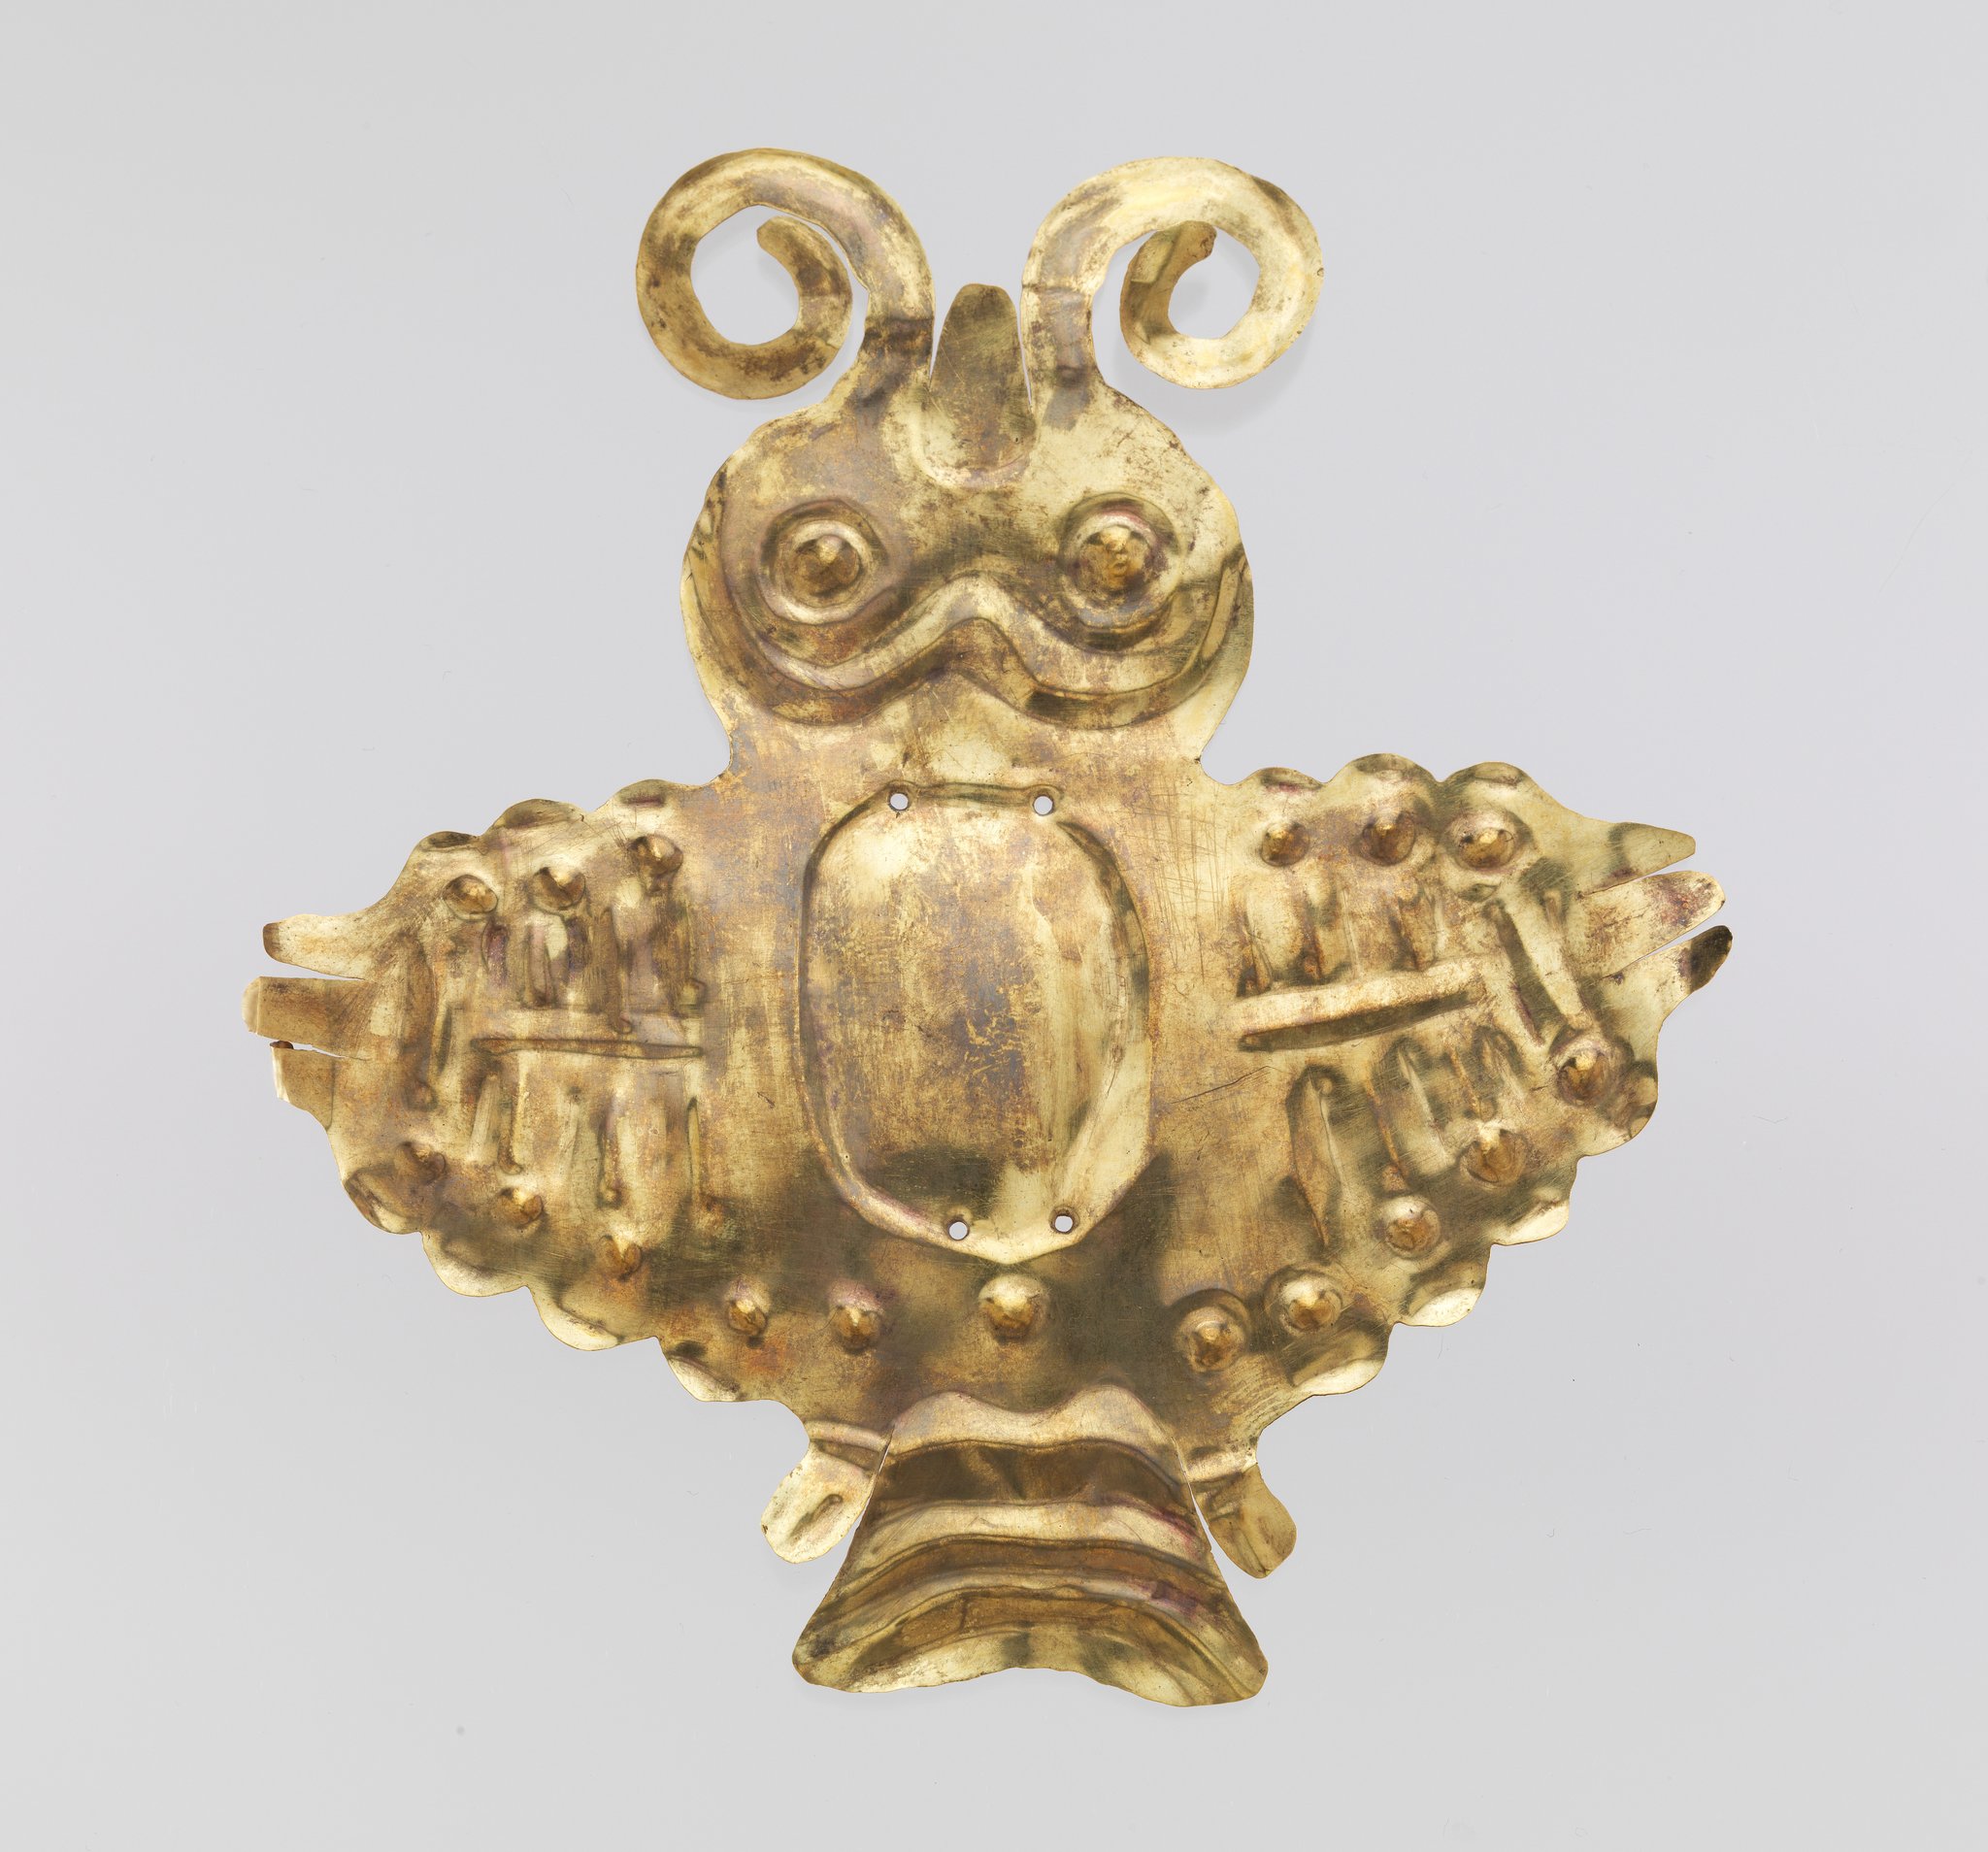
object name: ornament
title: Bird-shaped ornament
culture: nasca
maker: nasca artist(s)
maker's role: artist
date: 1-700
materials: gold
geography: peru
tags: birds